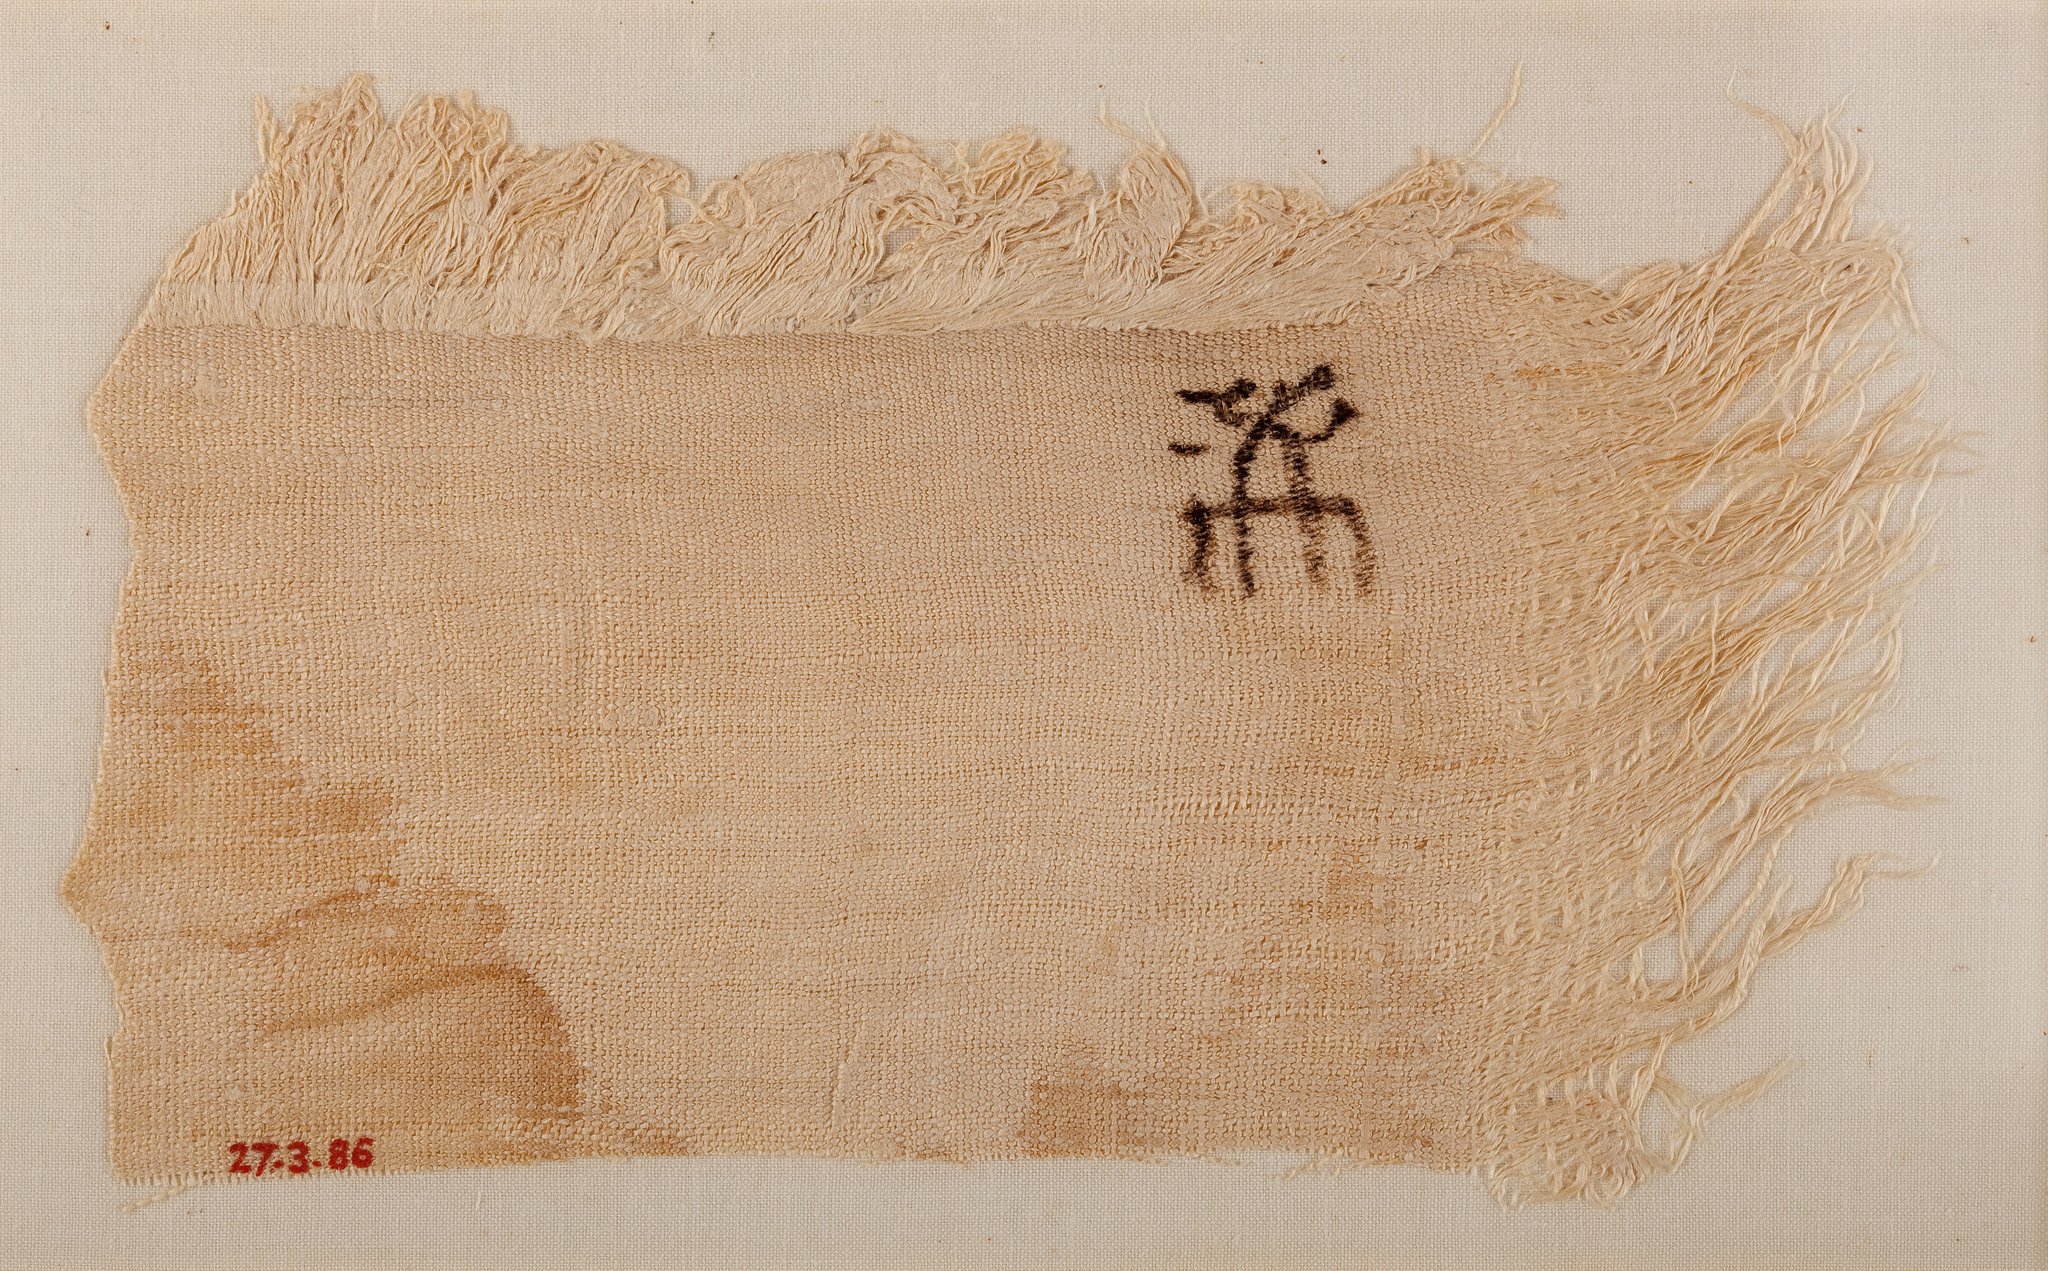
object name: linen mark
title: Linen mark (Type I)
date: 1961-1917 BCE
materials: linen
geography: egypt